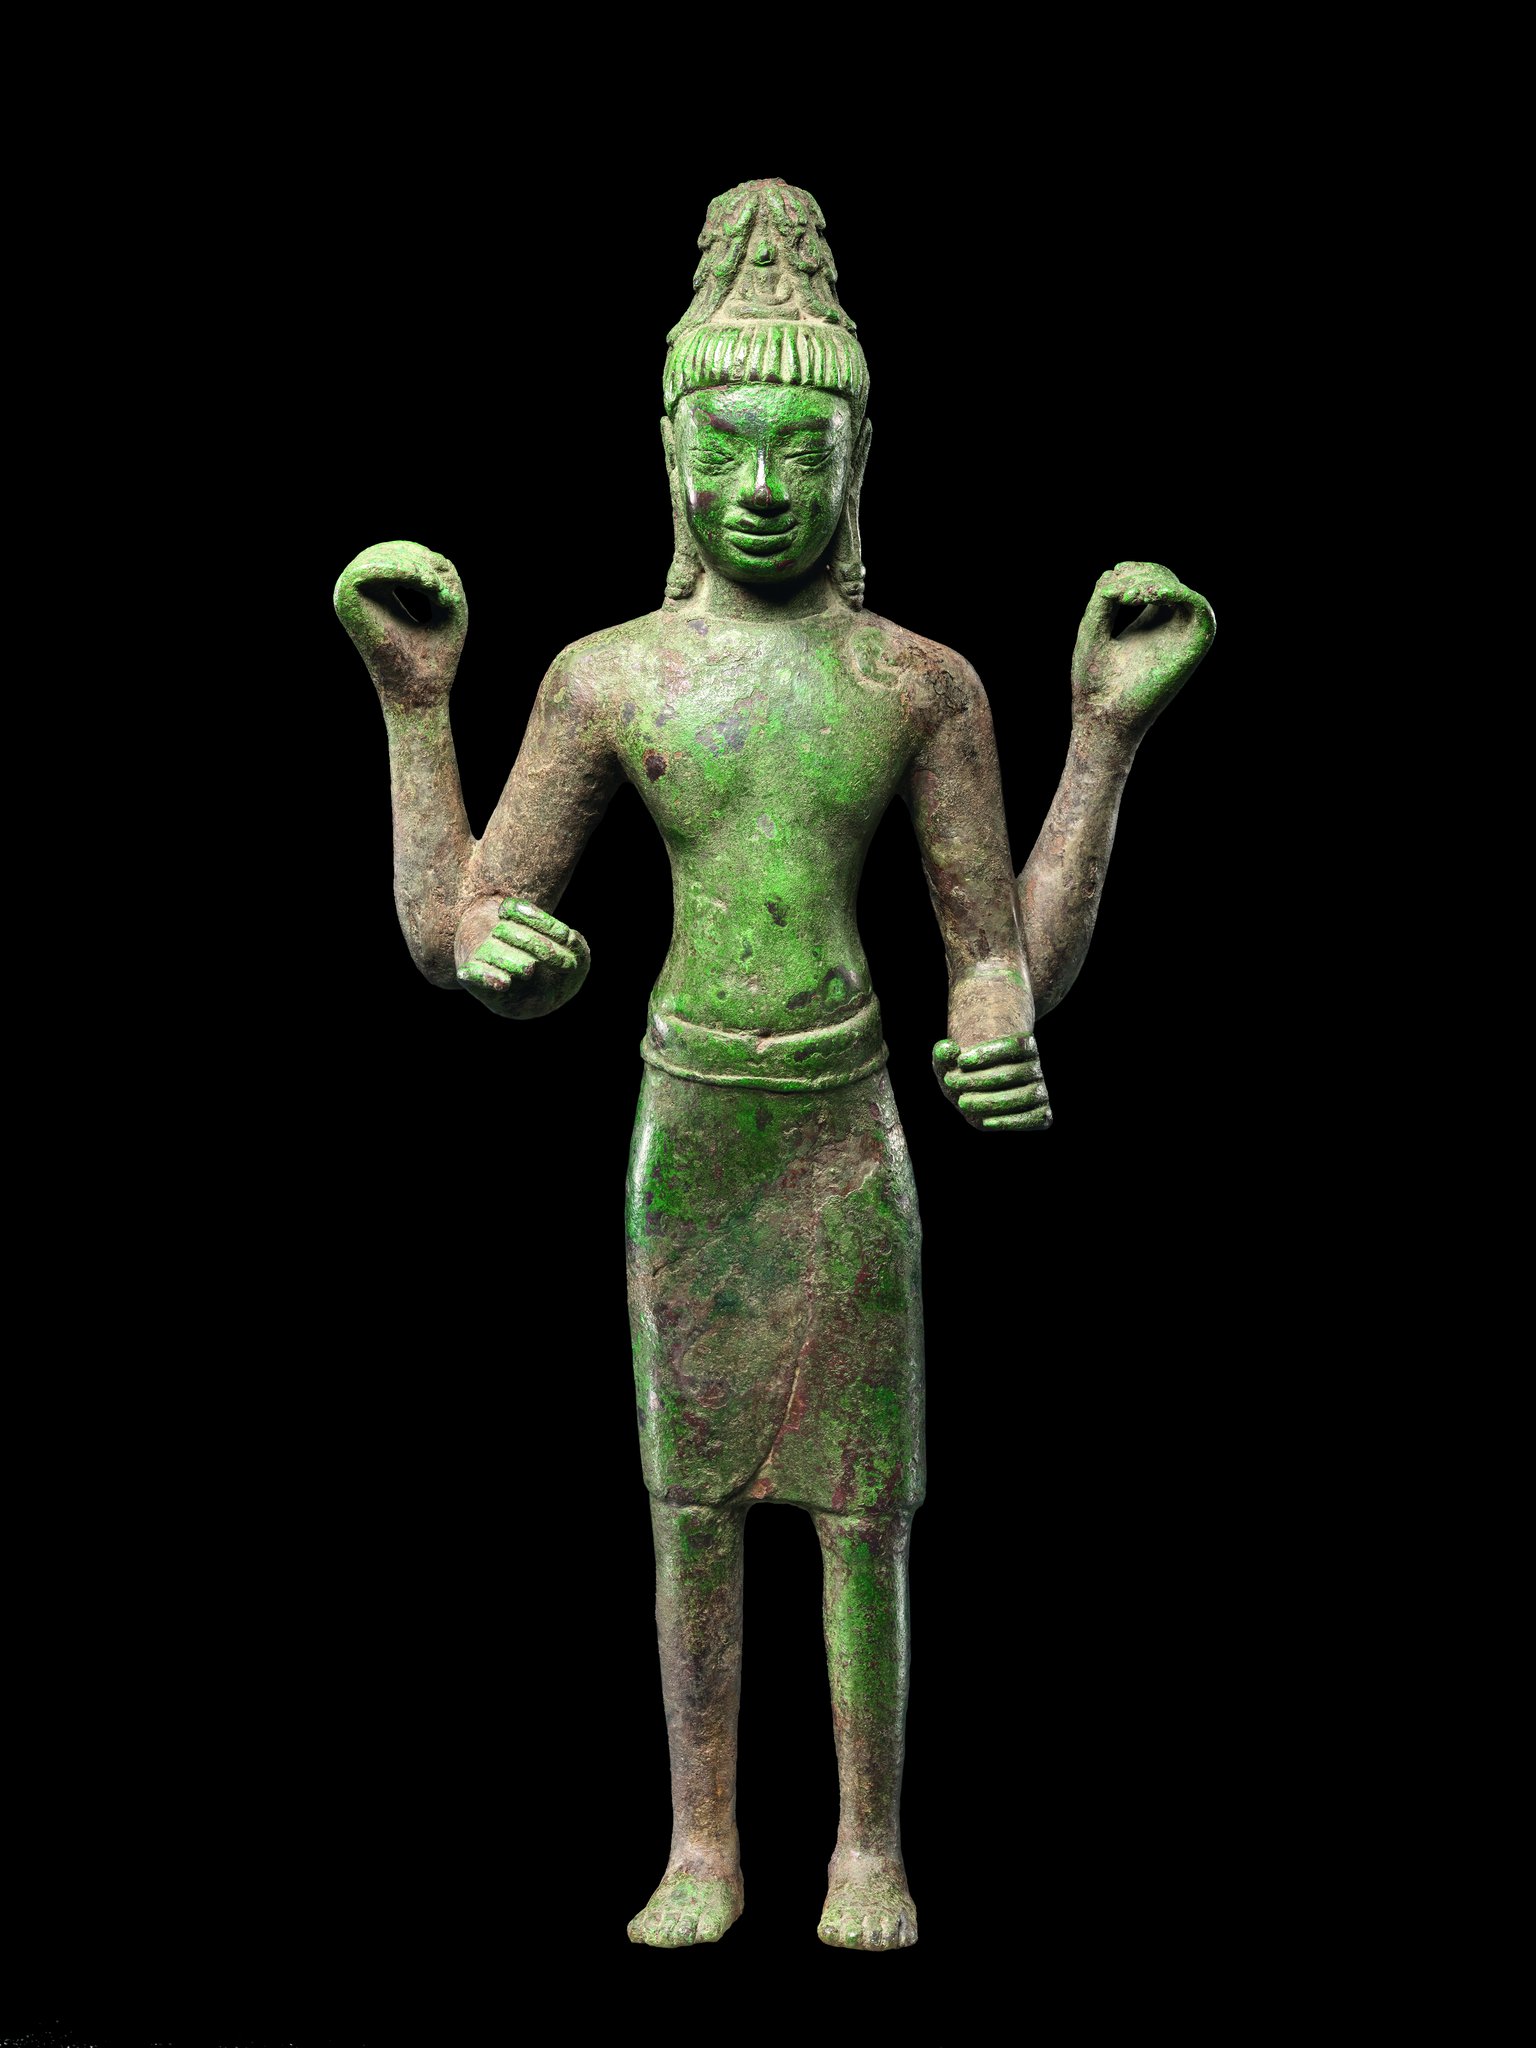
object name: figure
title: Bodhisattva Avaolkiteshvara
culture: cambodian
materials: copper alloy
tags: buddhism,avalokiteshvara,bodhisattvas